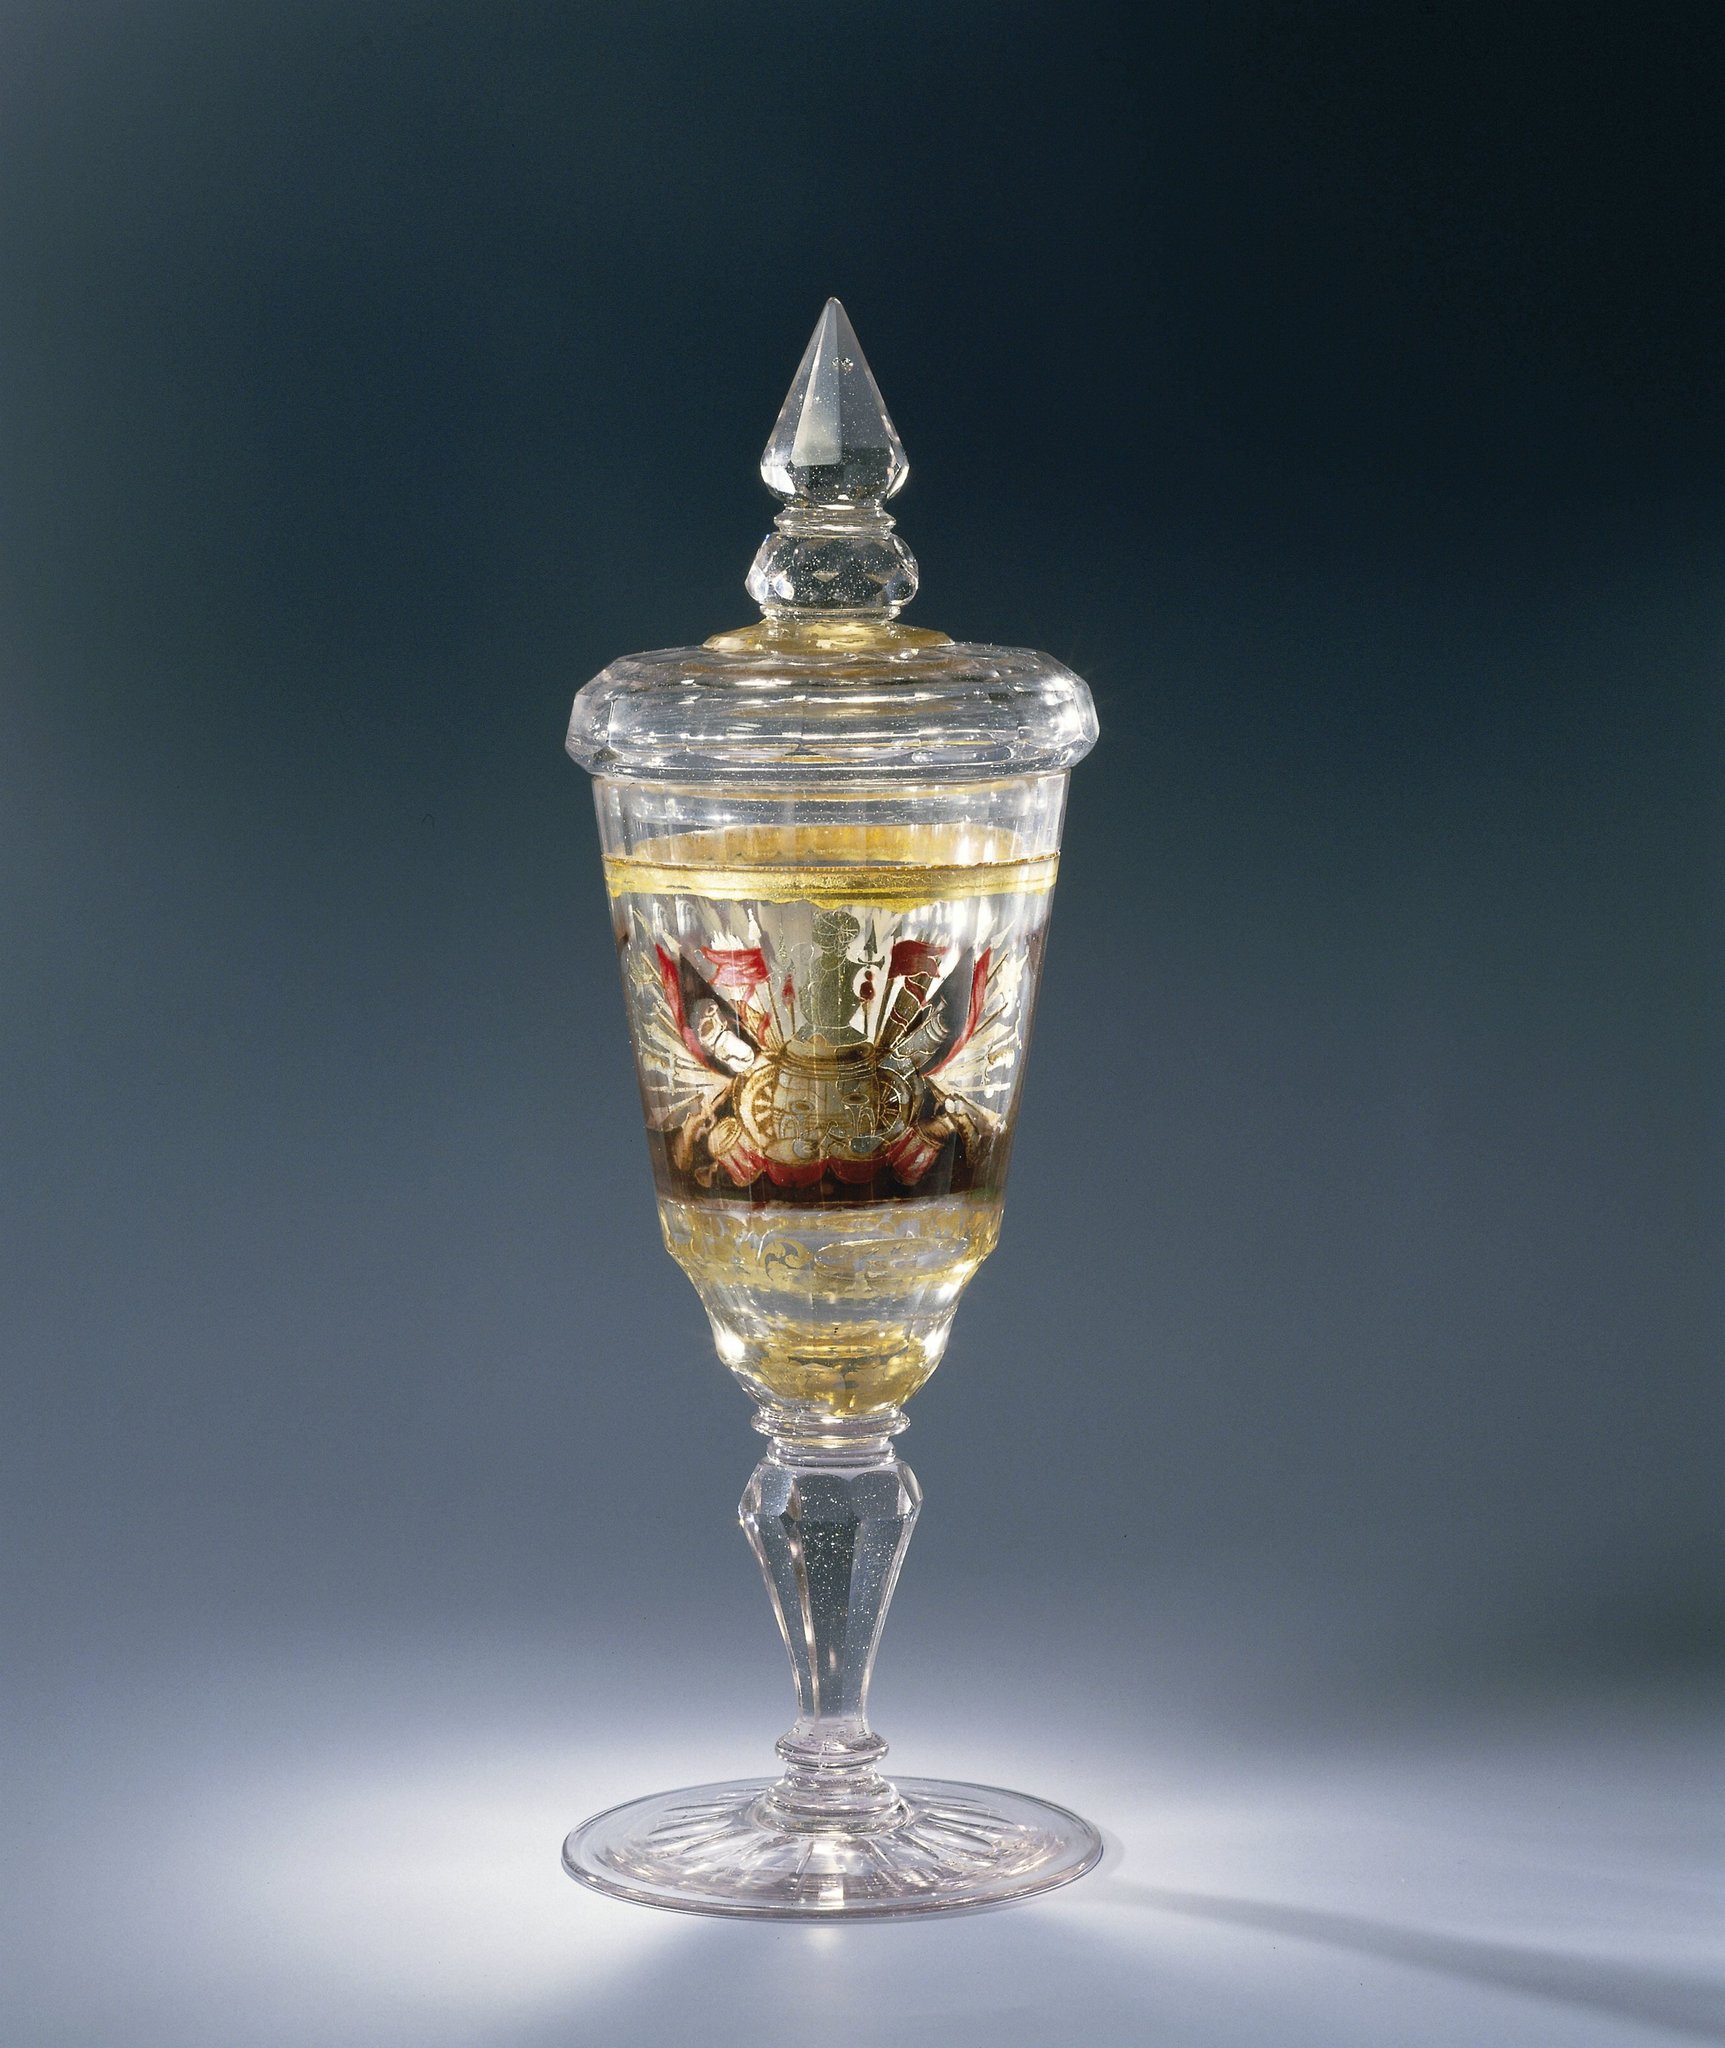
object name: lid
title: Bokaal met deksel van Zwischengoldglas, met een kruitvat met wapentrofee en een bloemenmand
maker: Anonymous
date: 1720-1740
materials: glass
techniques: glassblowing, grinding, lacquer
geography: bohemia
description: Covered double-walled goblet. Gold and silver leaf, lacquer Bohemia, c. 1720 - 1740.